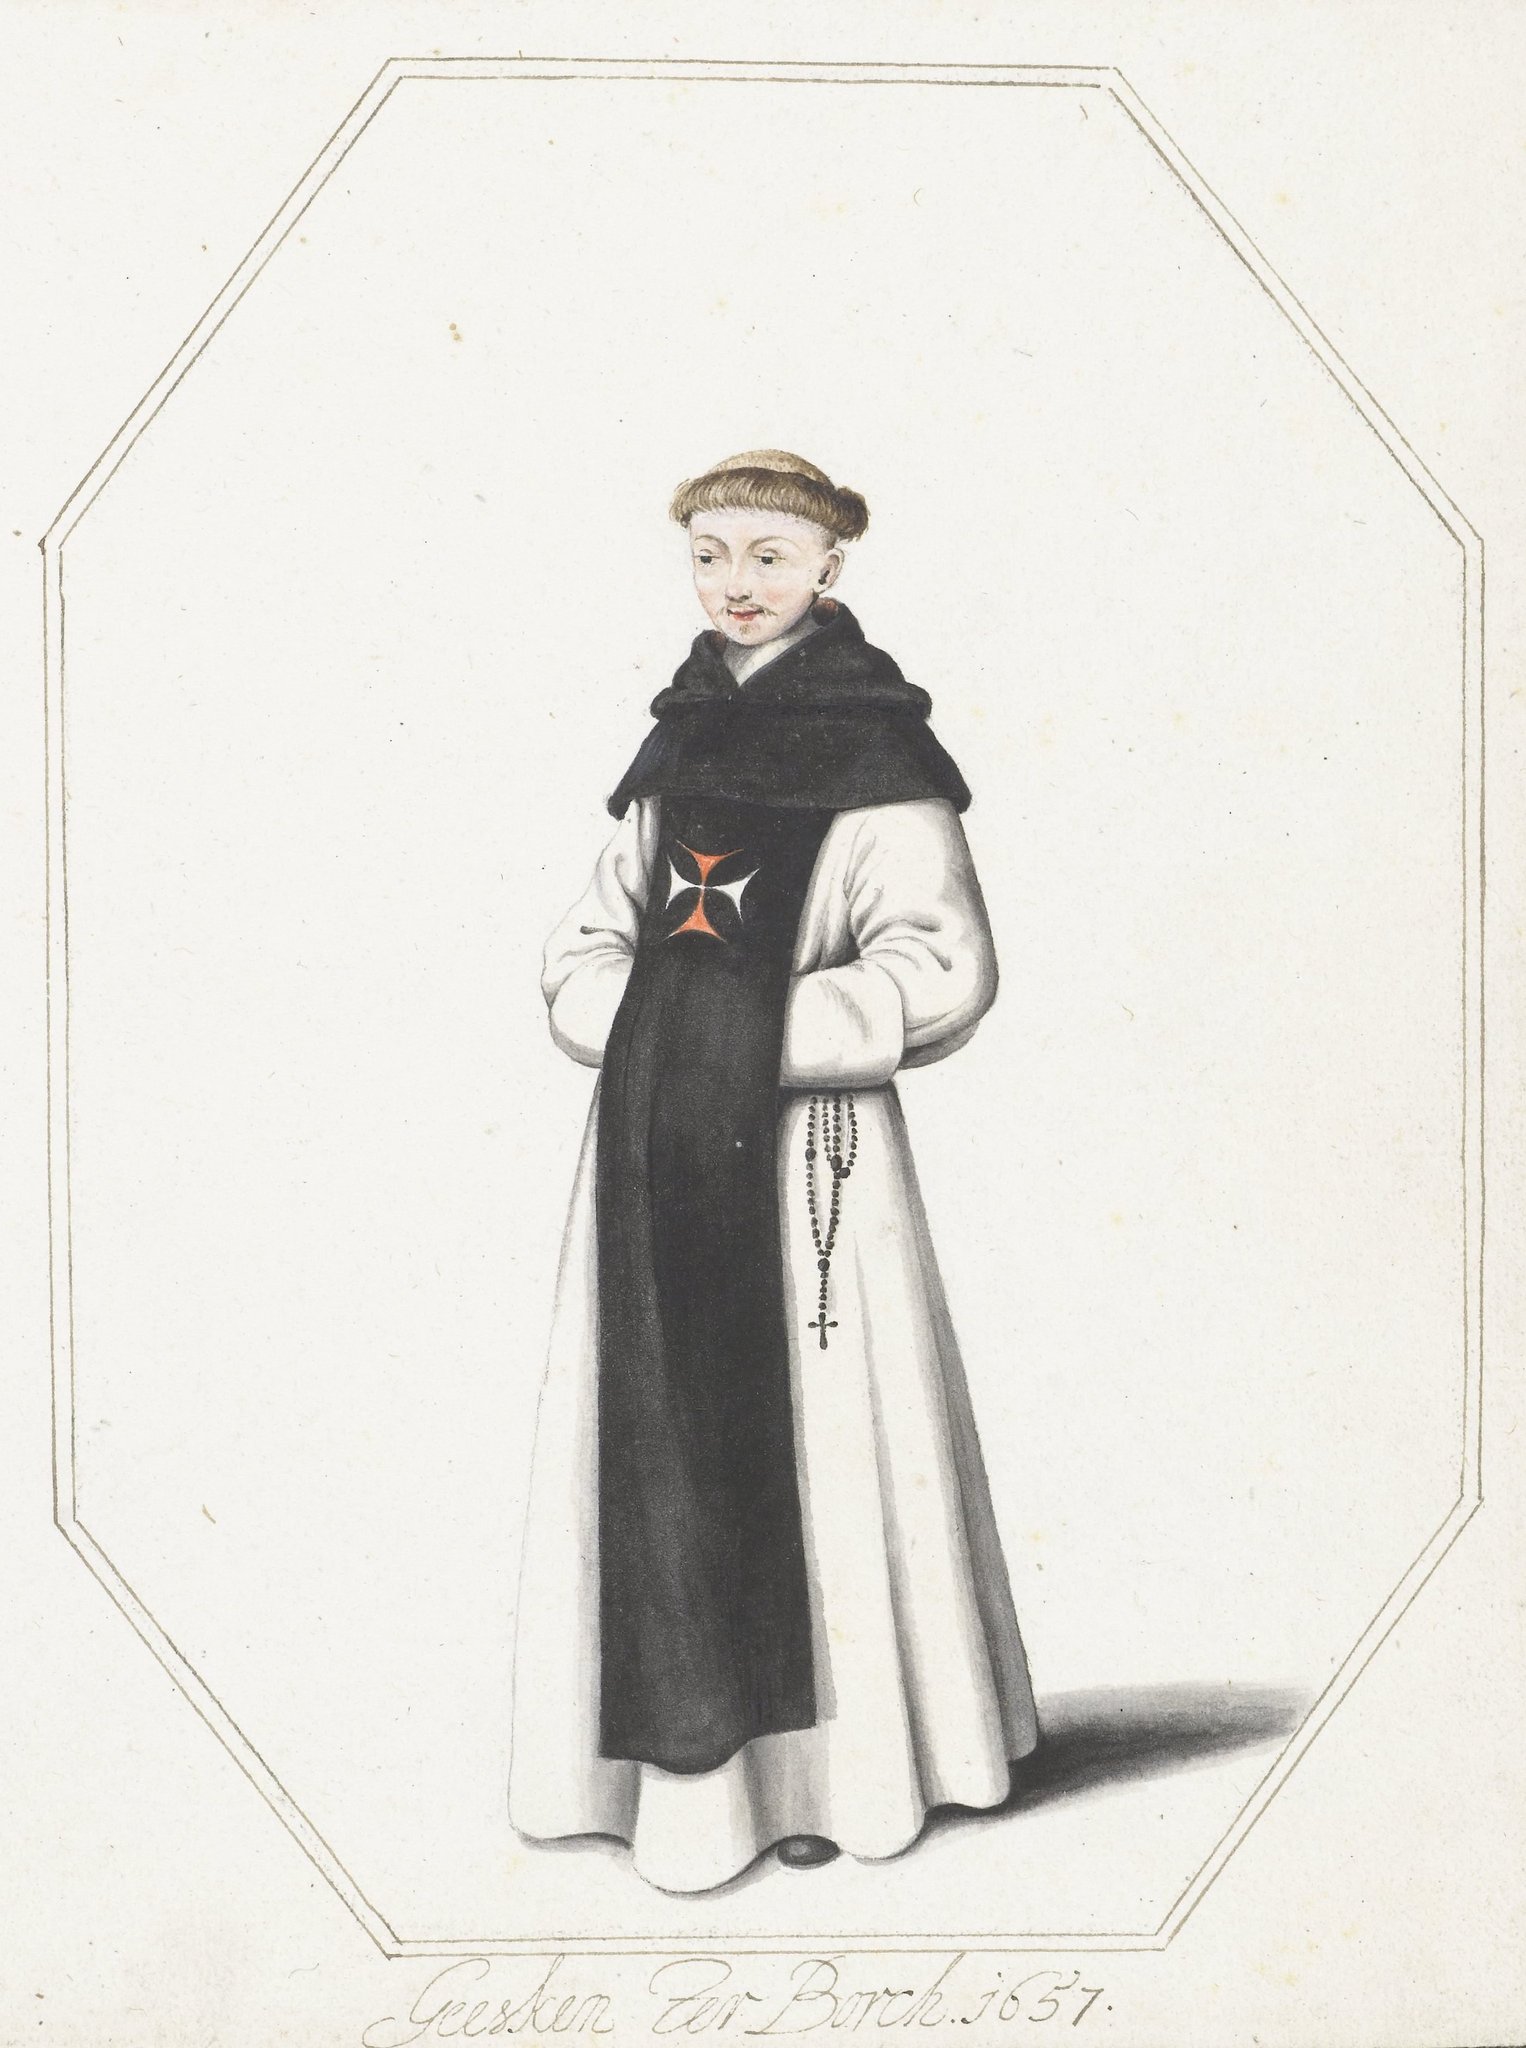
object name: drawing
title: Staande broeder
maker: gesina ter borch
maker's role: draughtsman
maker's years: 1633-1690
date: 1657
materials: ink, paper, watercolor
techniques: brush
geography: zwolle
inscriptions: signature and date: ‘Geesken Ter Borch. 1657’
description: Een van twee tekeningen gemaakt op hetzelfde blad.